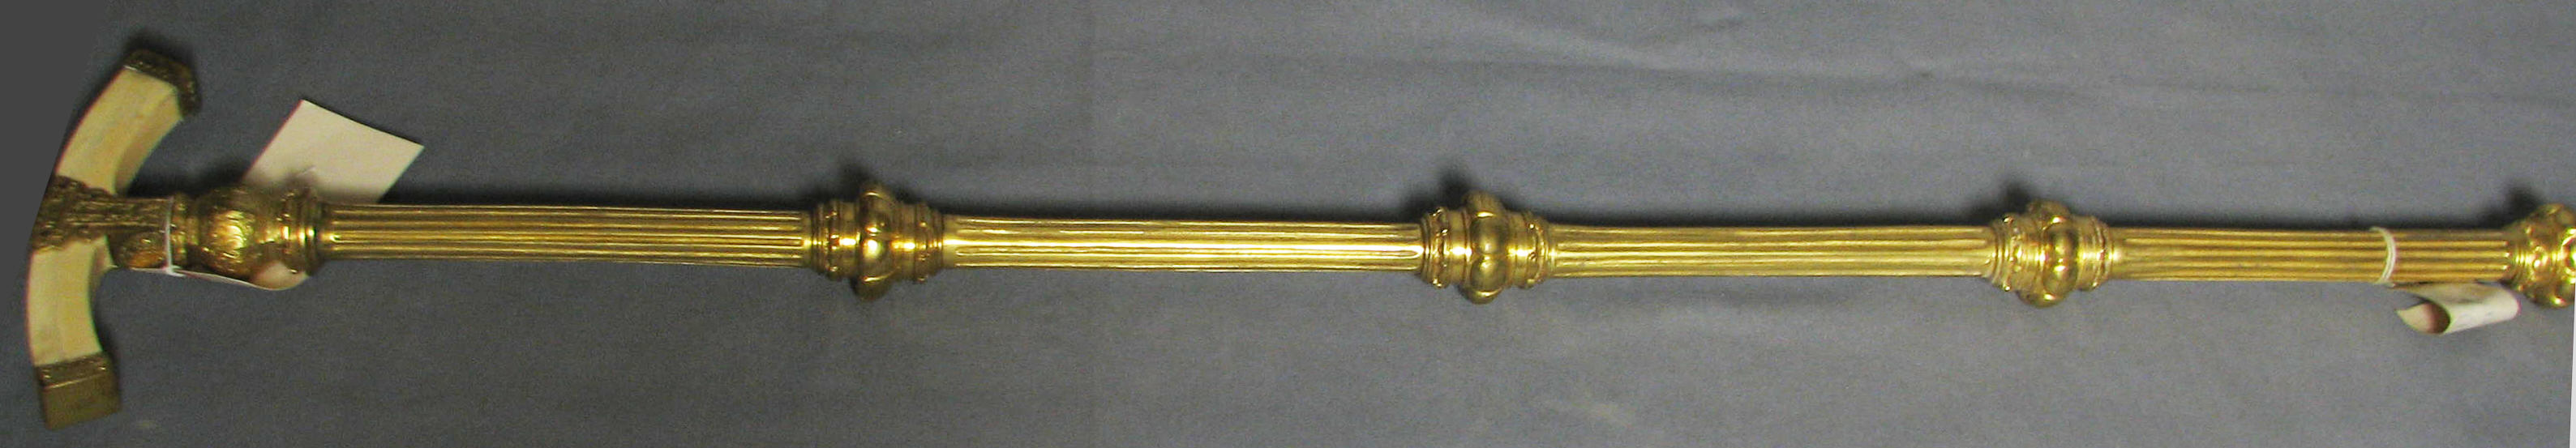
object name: pastoral staff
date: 1801-1900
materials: metal, silver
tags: cross,croziers